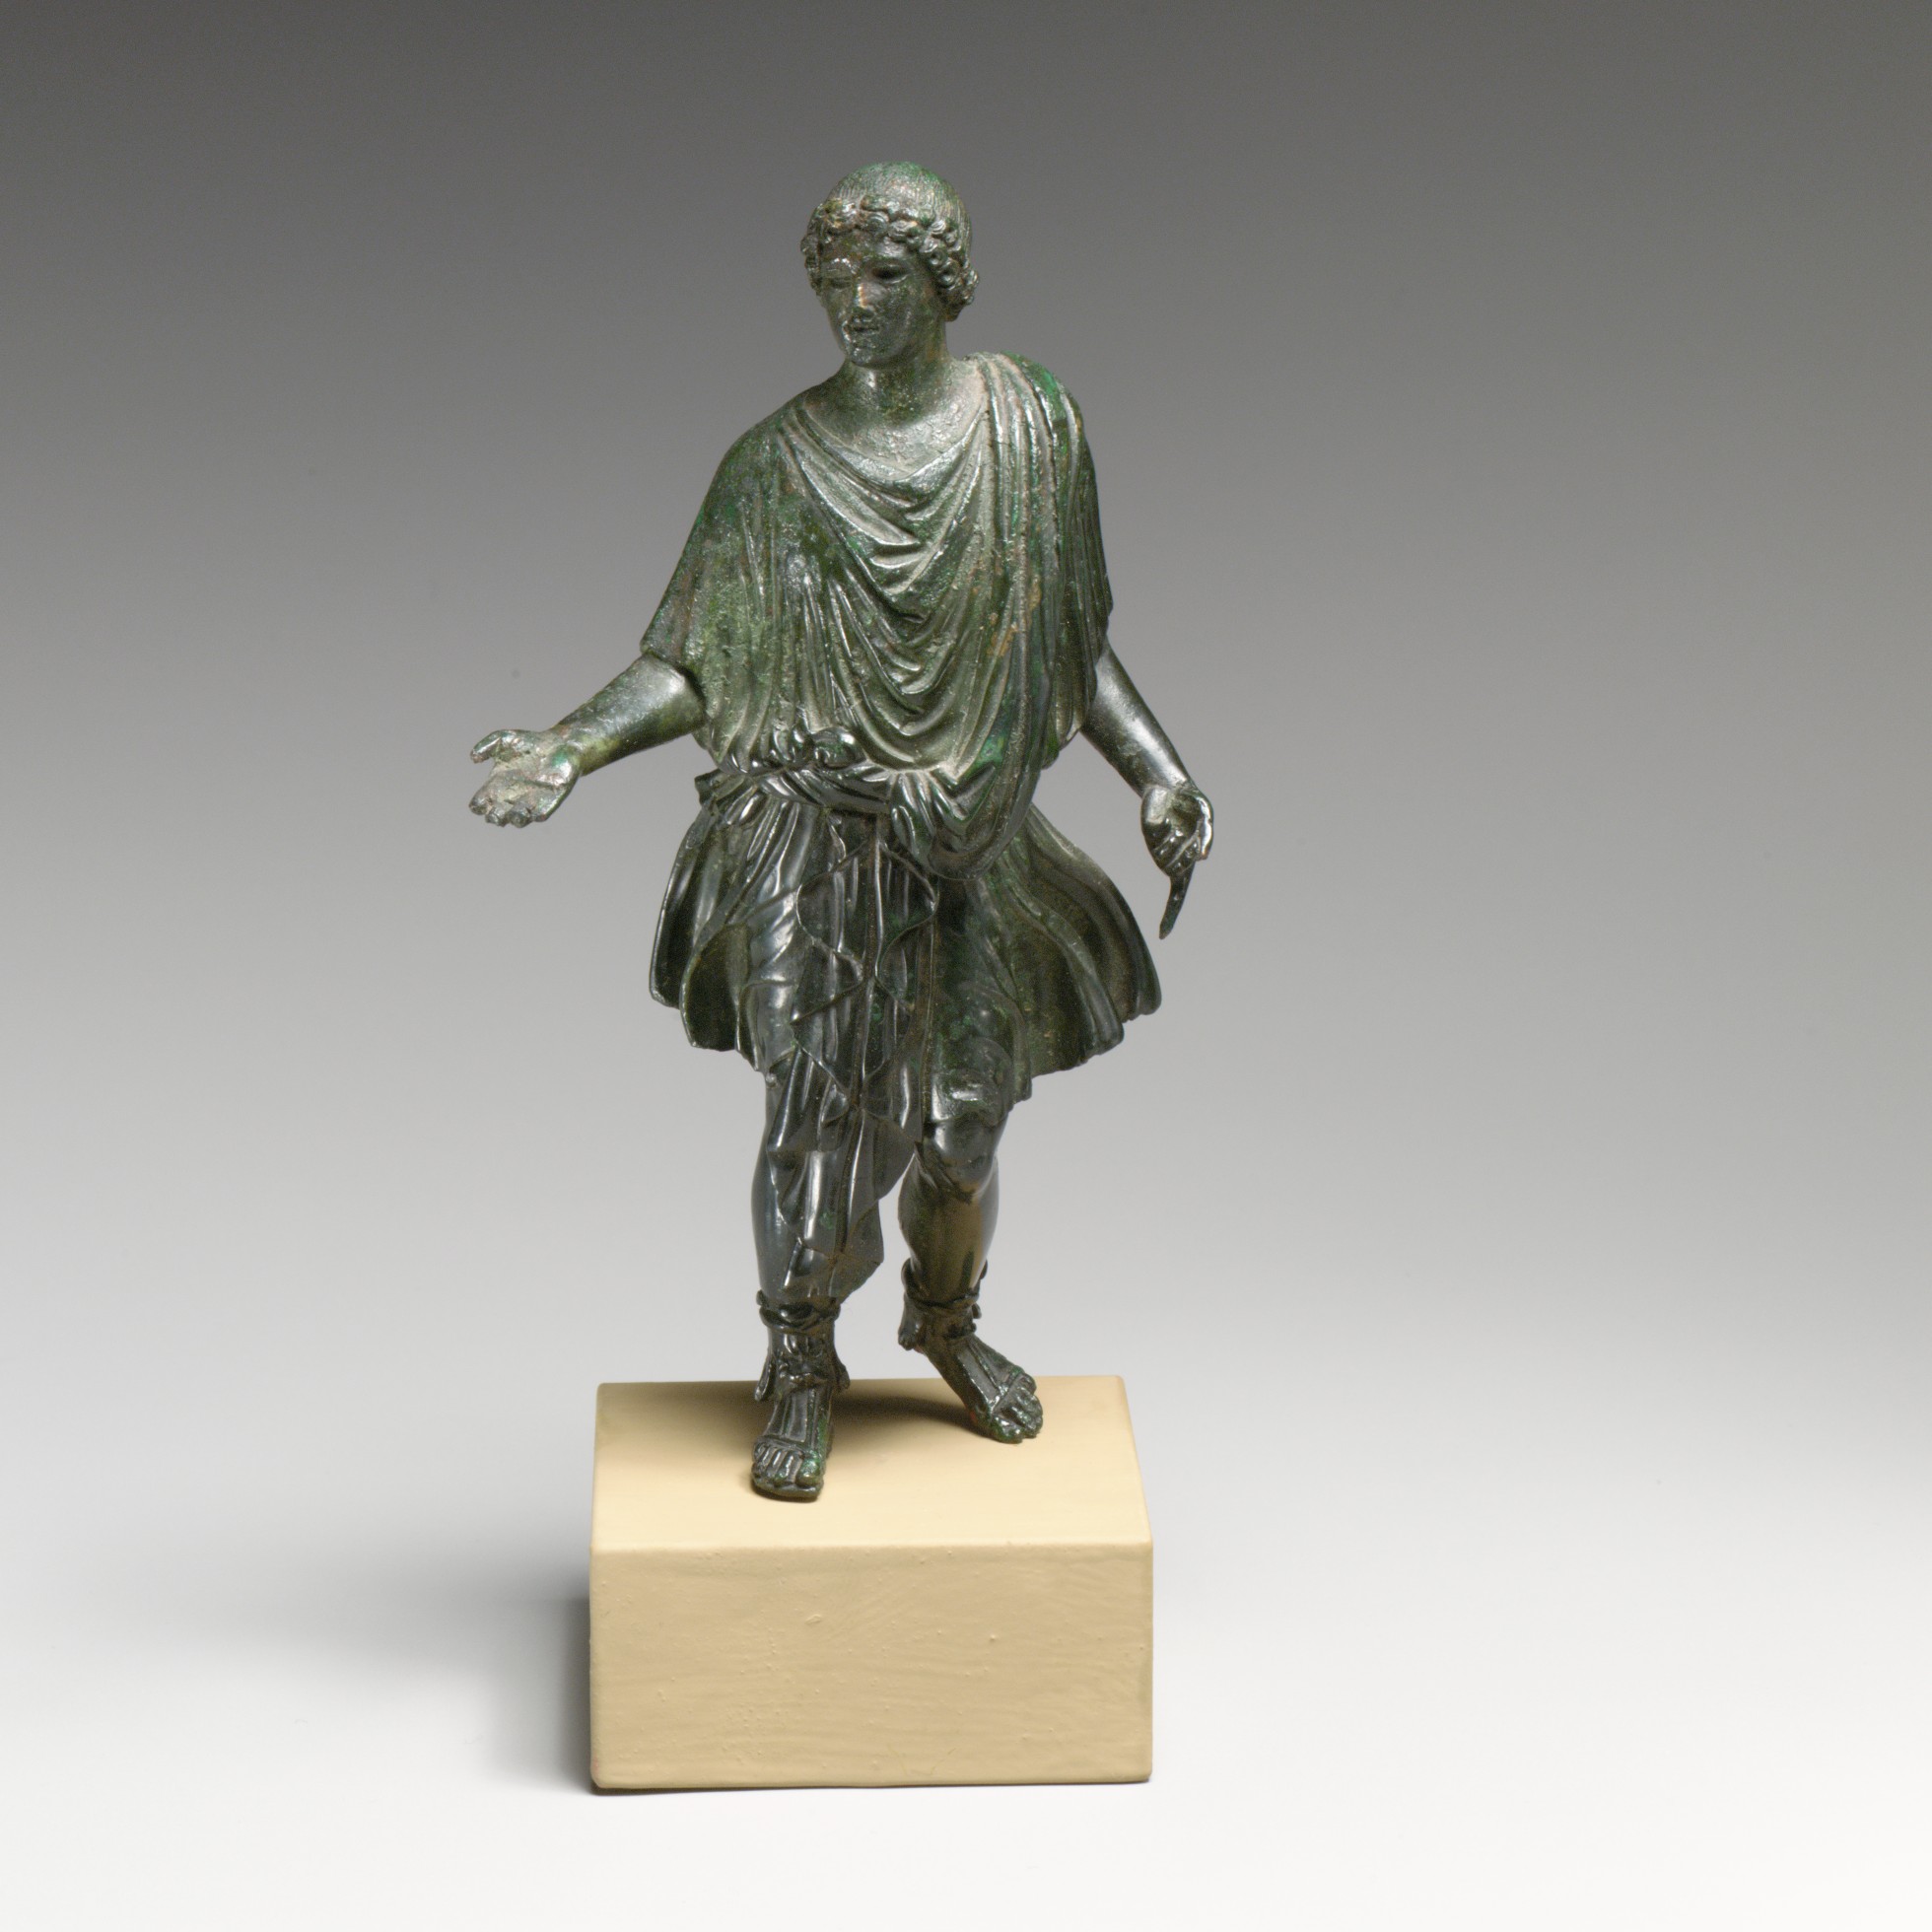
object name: statuette of a camillus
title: Bronze statuette of a camillus (attendant)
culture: roman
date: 50 BCE-50 CE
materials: bronze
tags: men